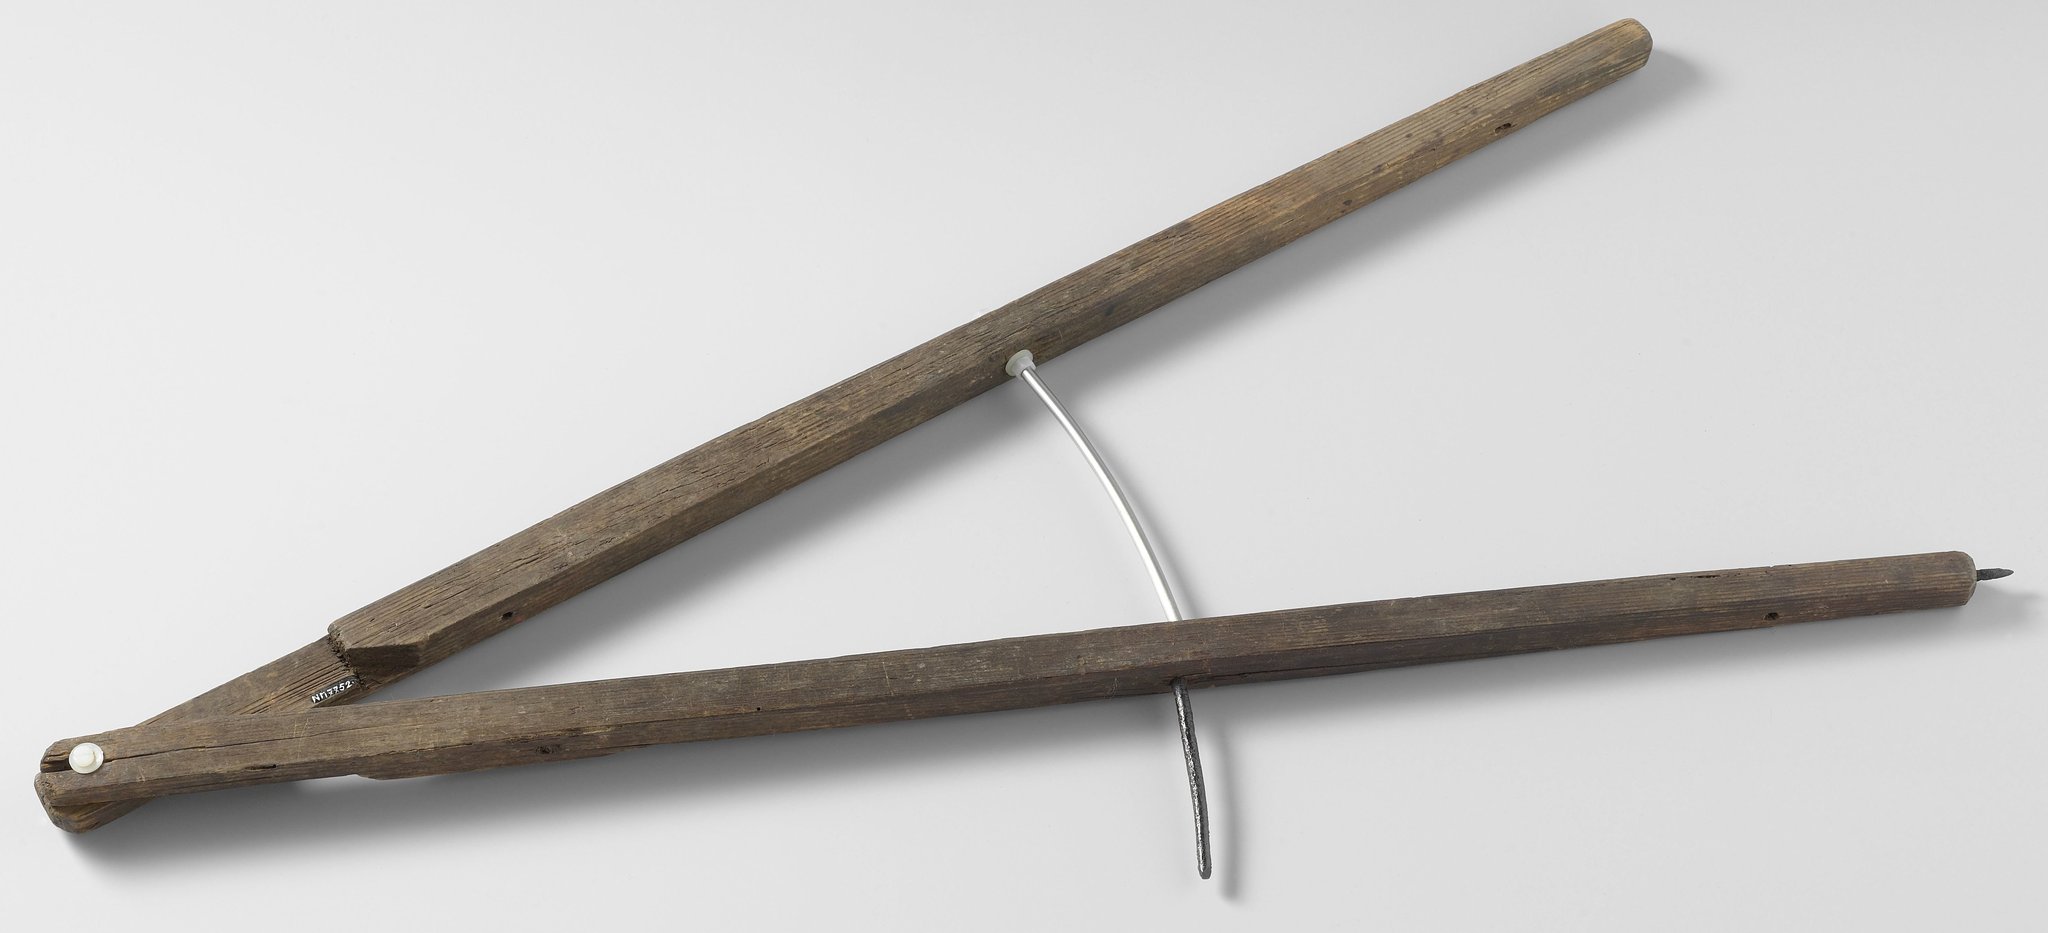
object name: compass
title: Passer met ijzeren pen en stuk van ijzeren geleidingsboog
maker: Anonymous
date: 1590-1596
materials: iron, wood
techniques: cutting, forging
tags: willem barendsz., amsterdam, jacob van heemskerck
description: Passer met ijzeren pen en stuk van ijzeren geleidingsboog. De twee rechte benen waren middels een scharnier verenigd. Het ijzer is grotendeels verloren gegaan.